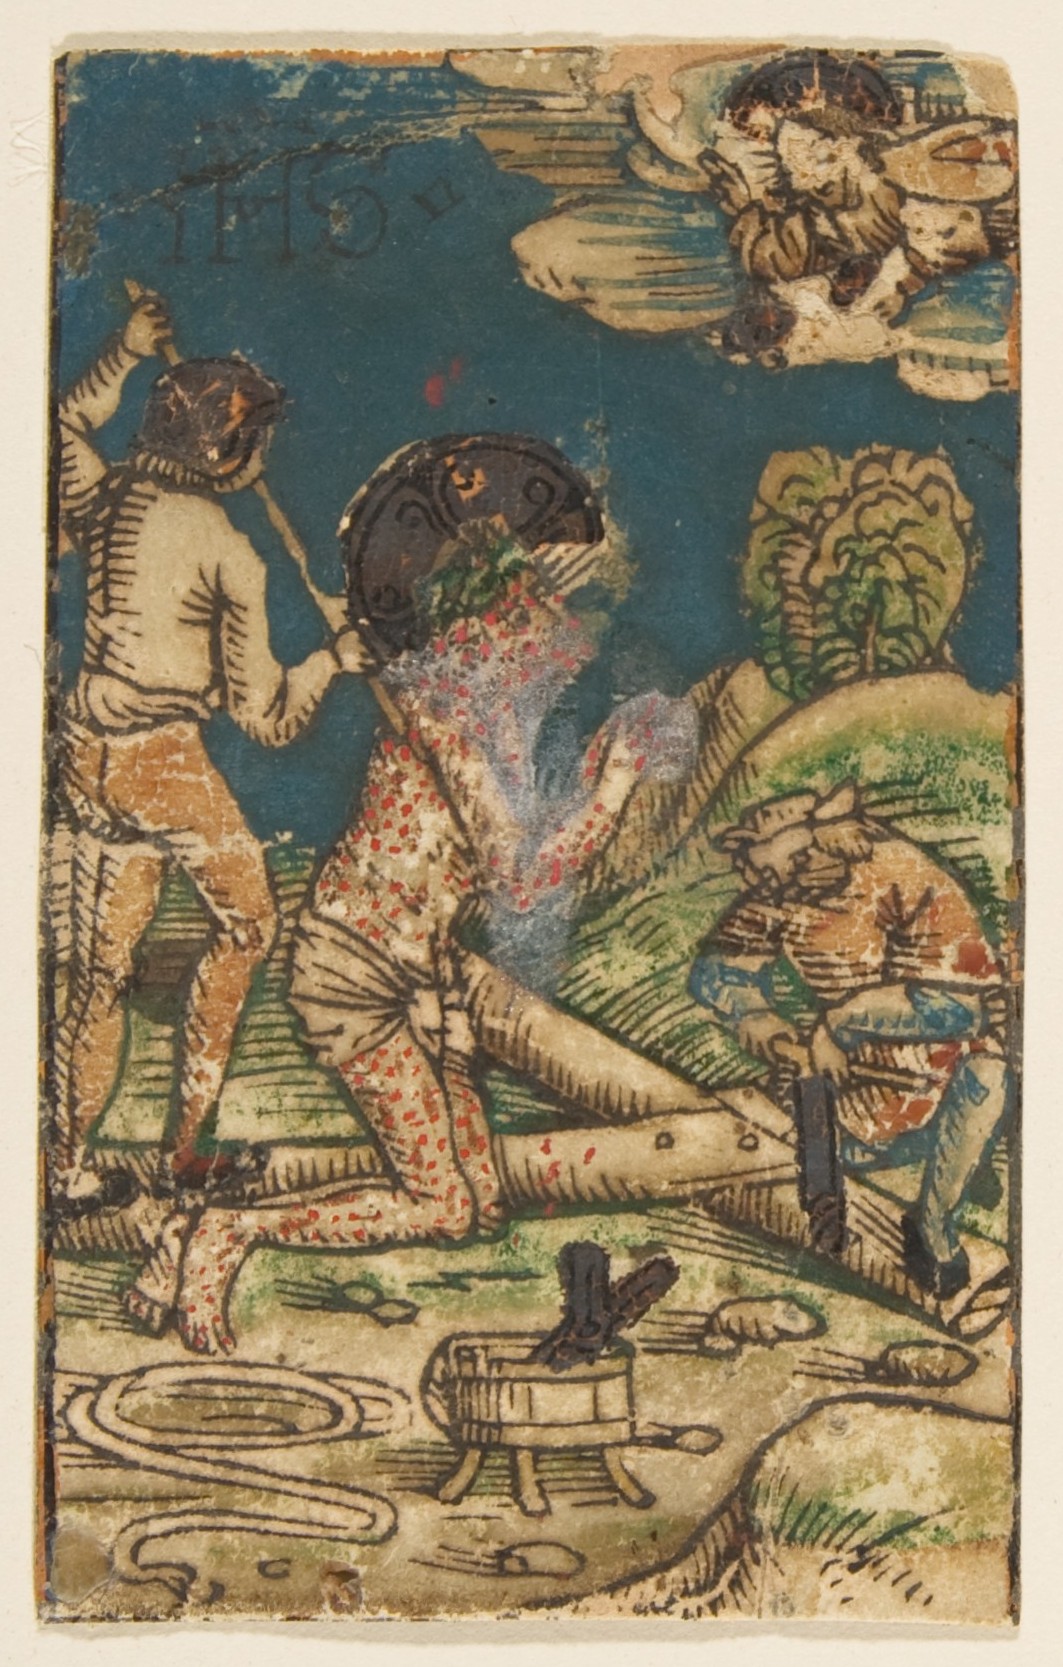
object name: print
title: Preparation for the Crucifixion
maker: anonymous, german, 15th century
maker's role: artist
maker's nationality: german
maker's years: 1400-1500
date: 1401-1500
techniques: hand coloring, woodcut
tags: men,angels,jesus